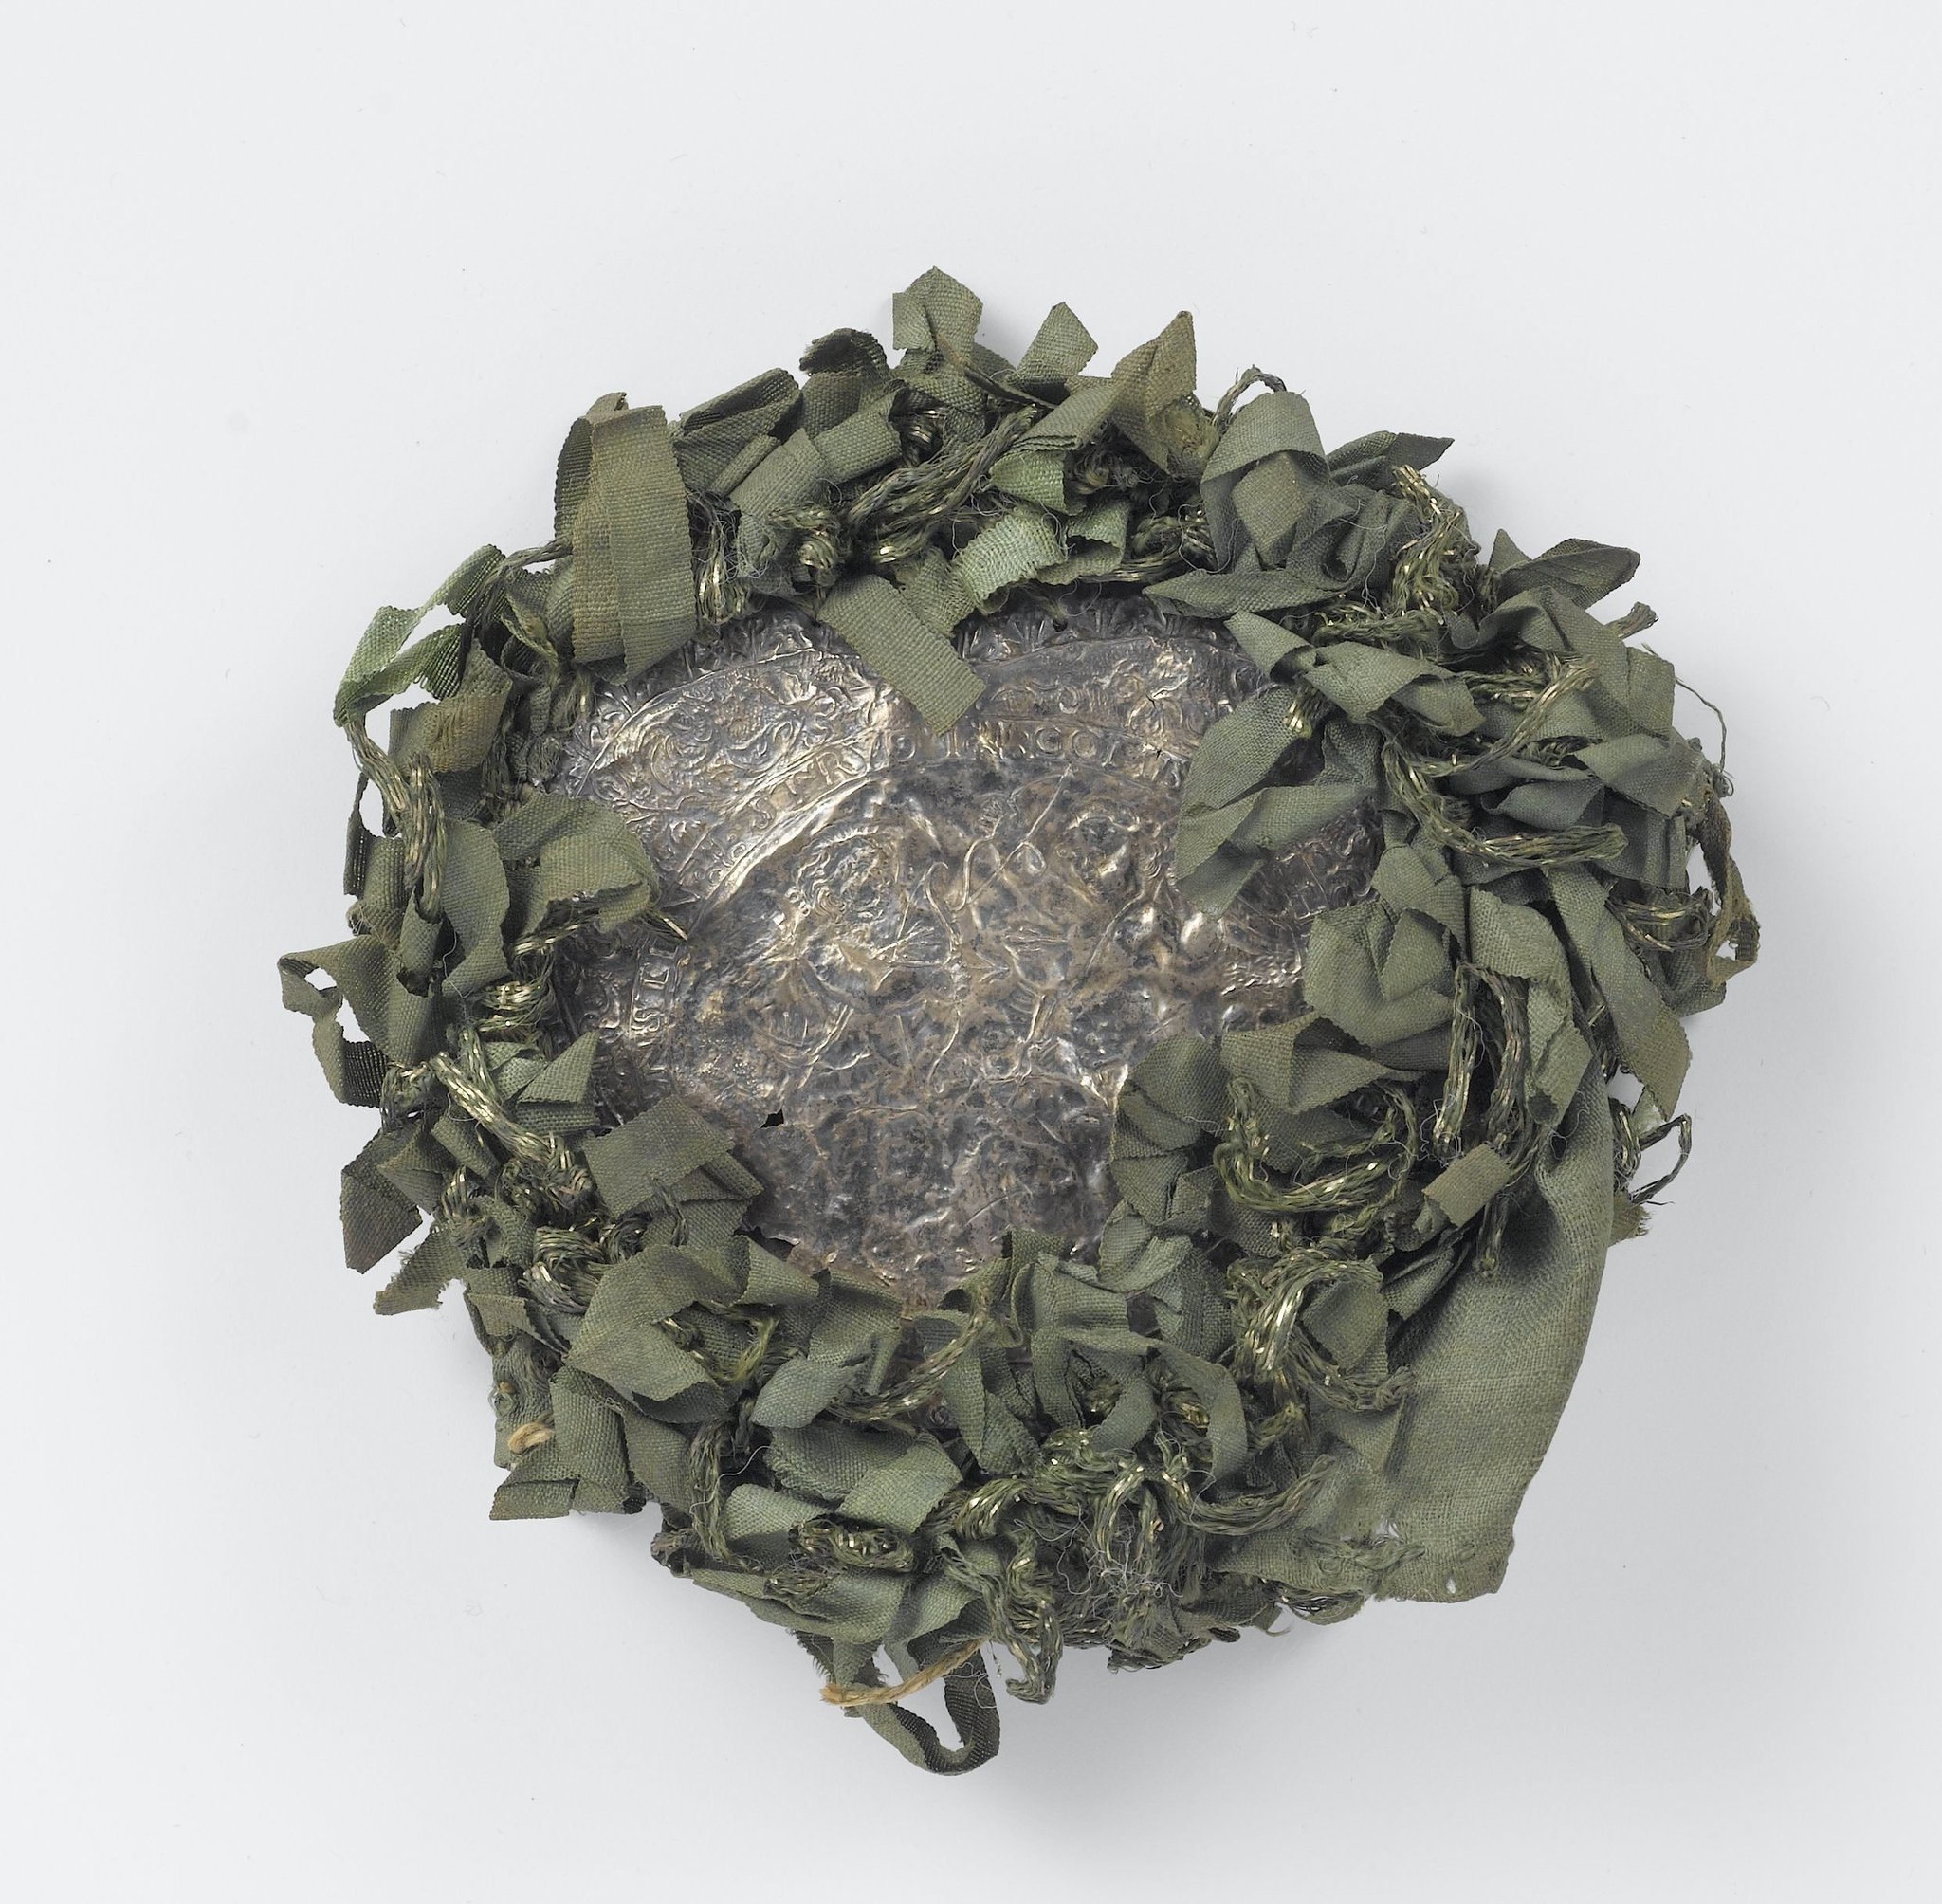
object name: knottepong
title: Beurs, bestaande uit twee harten van plaatzilver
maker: Anonymous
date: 1620-1640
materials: gold thread, silk, silver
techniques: repoussé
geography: netherlands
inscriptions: inscription: ‘Gewenschten Strijd Combat Heureux’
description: Bruidshart, twee harten van gedreven plaatzilver, zijde, gouddraad ‘Gewenschten Stryd Combat Heureux’ Nederland, ca. 1620-1640 Inv. BK-1978-387